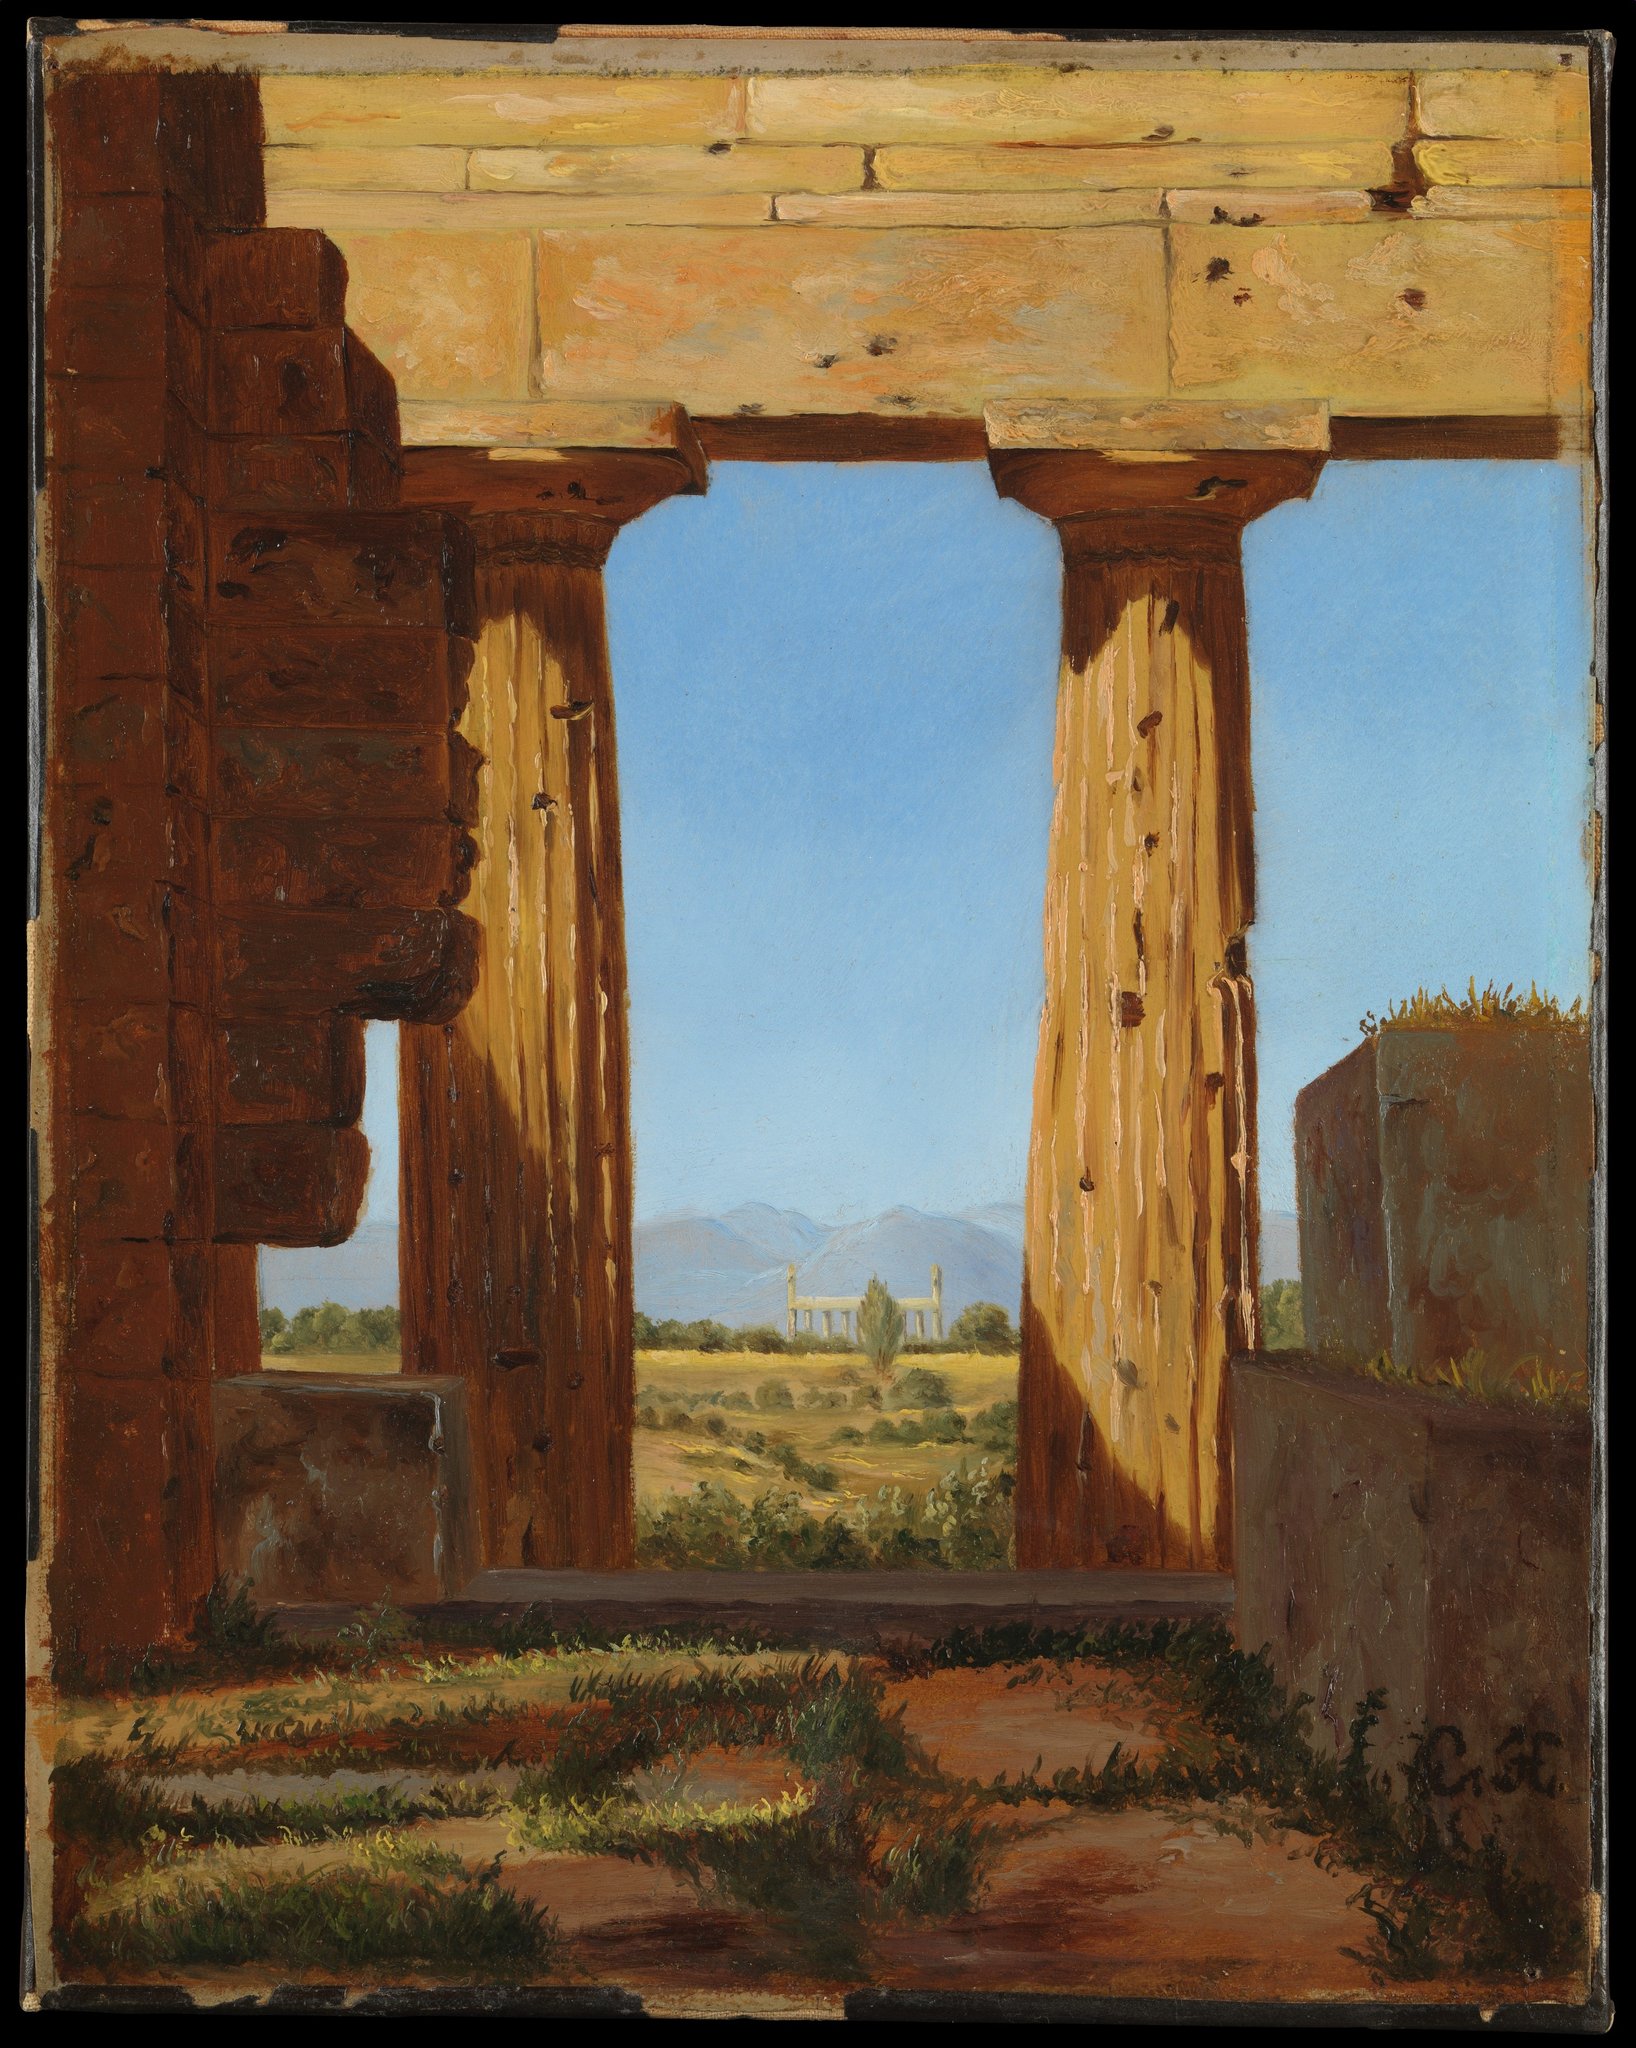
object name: painting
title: Columns of the Temple of Neptune at Paestum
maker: constantin hansen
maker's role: artist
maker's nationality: danish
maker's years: 1804-1880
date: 1838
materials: canvas, oil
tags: columns,temples,ruins